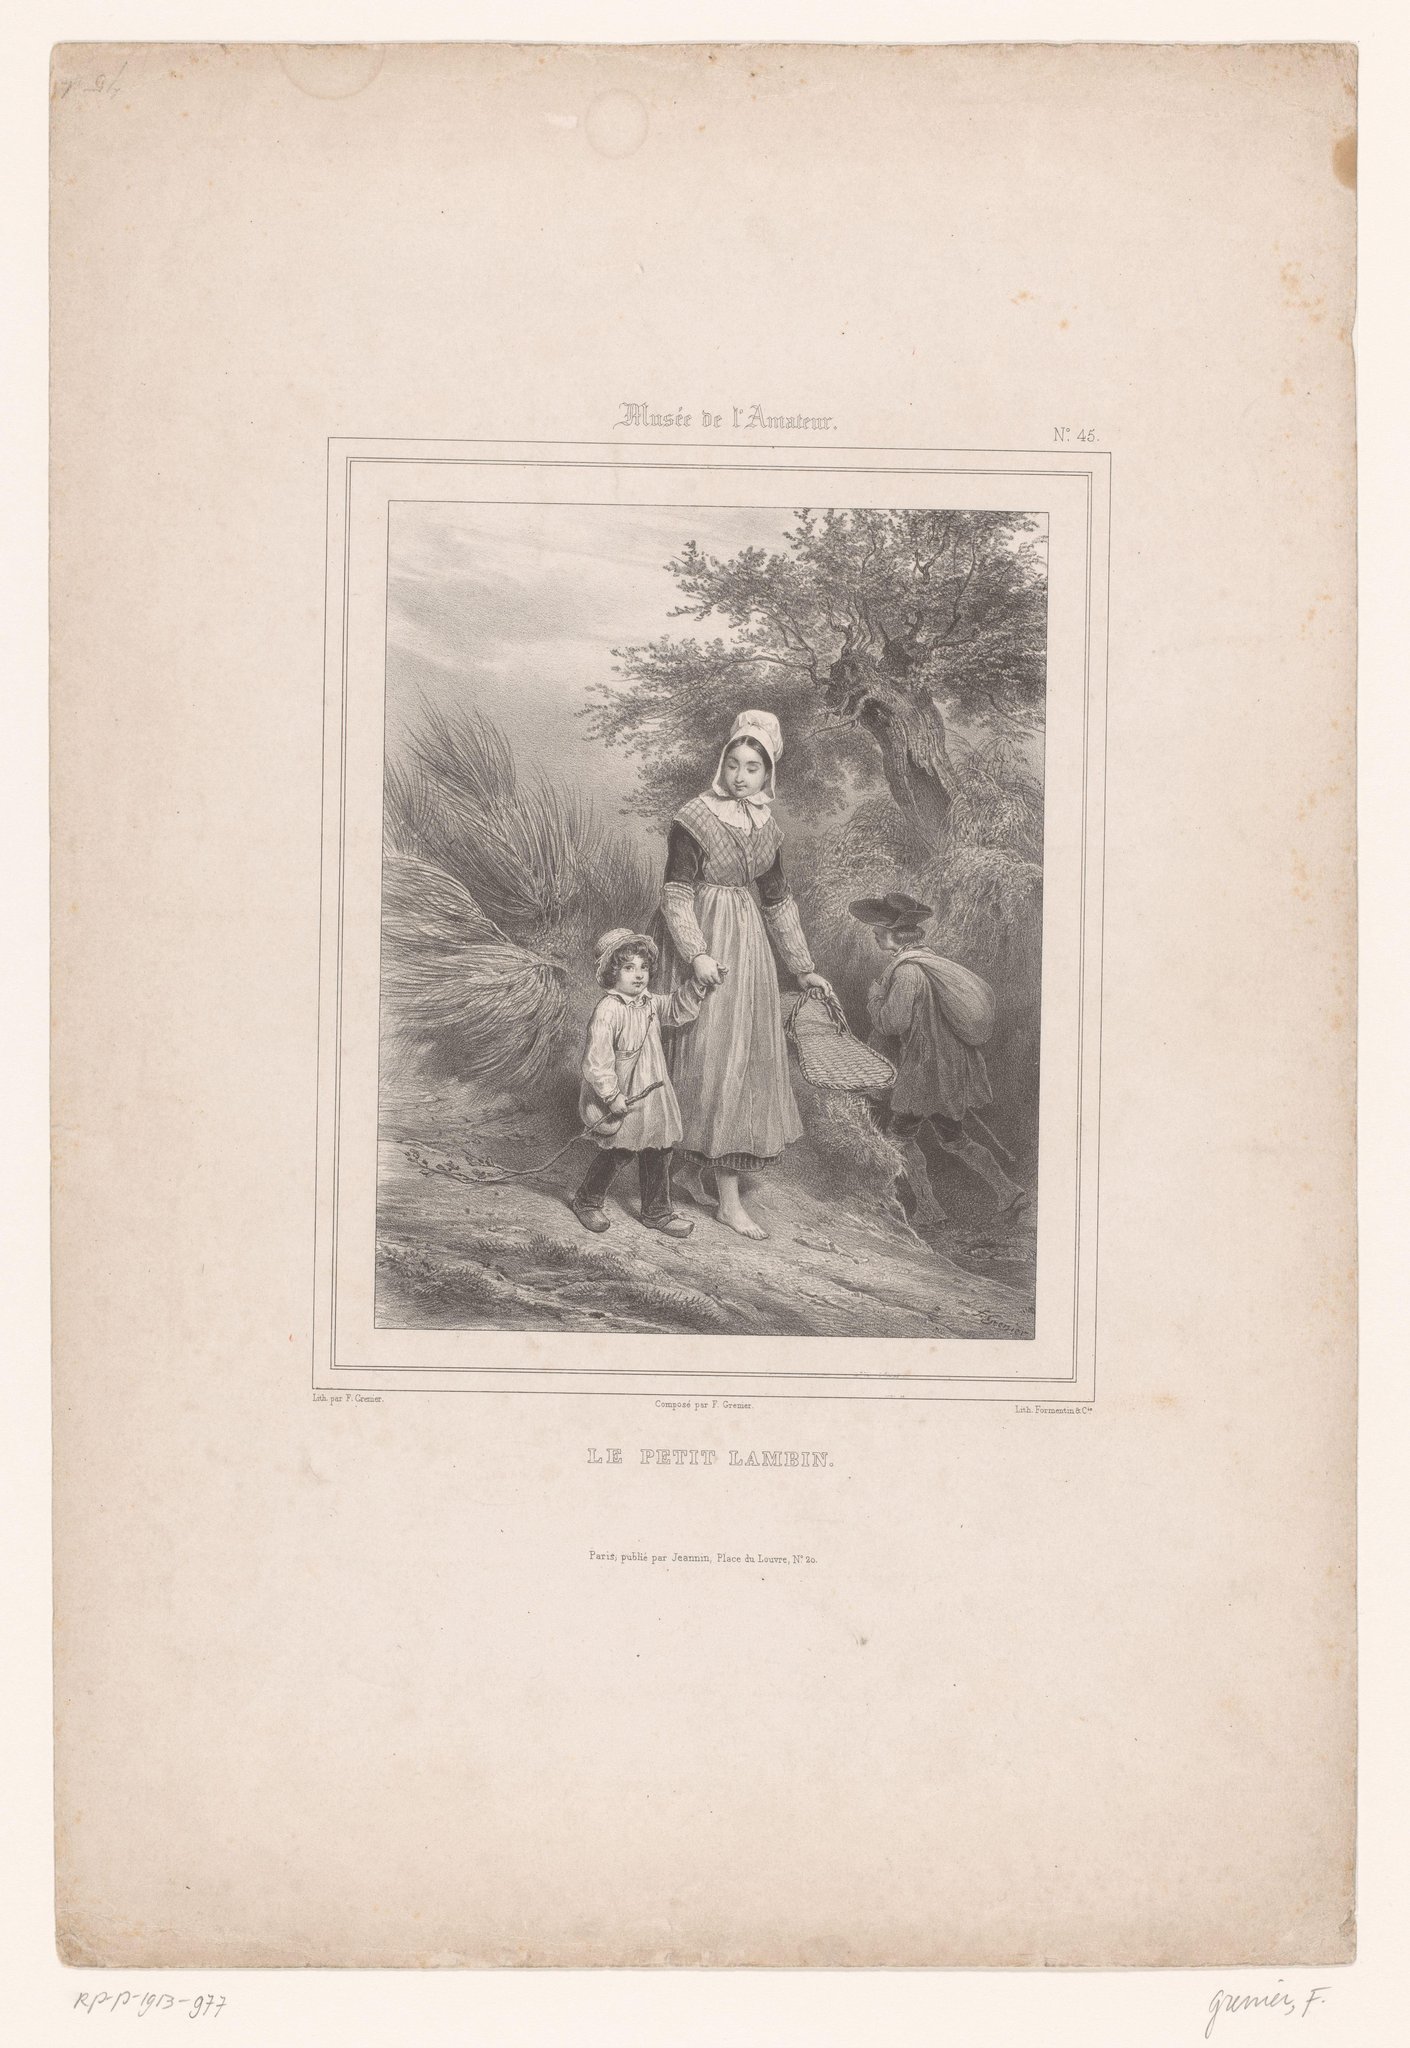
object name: print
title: Museum voor de kunstliefhebber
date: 1837-1838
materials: paper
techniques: lithograph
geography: paris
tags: dune coast, toddler, road, path, mother and baby or young child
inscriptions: check stamp: Lugt 1397c, collector's mark: Lugt 2228a